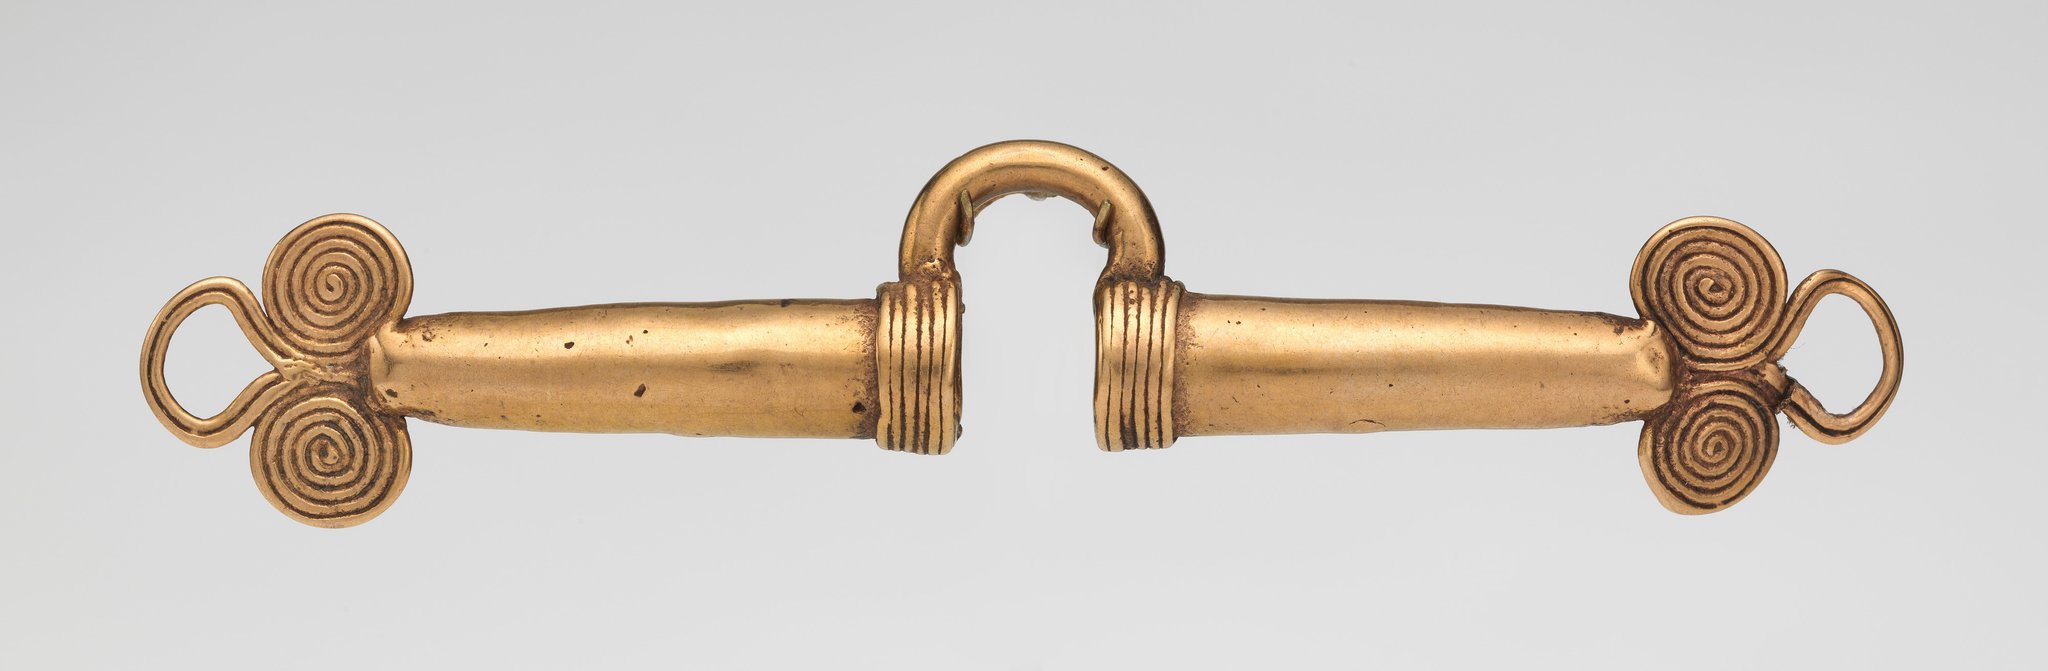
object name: ornament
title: Nose Ornament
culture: zenú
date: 1-1000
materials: gold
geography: colombia